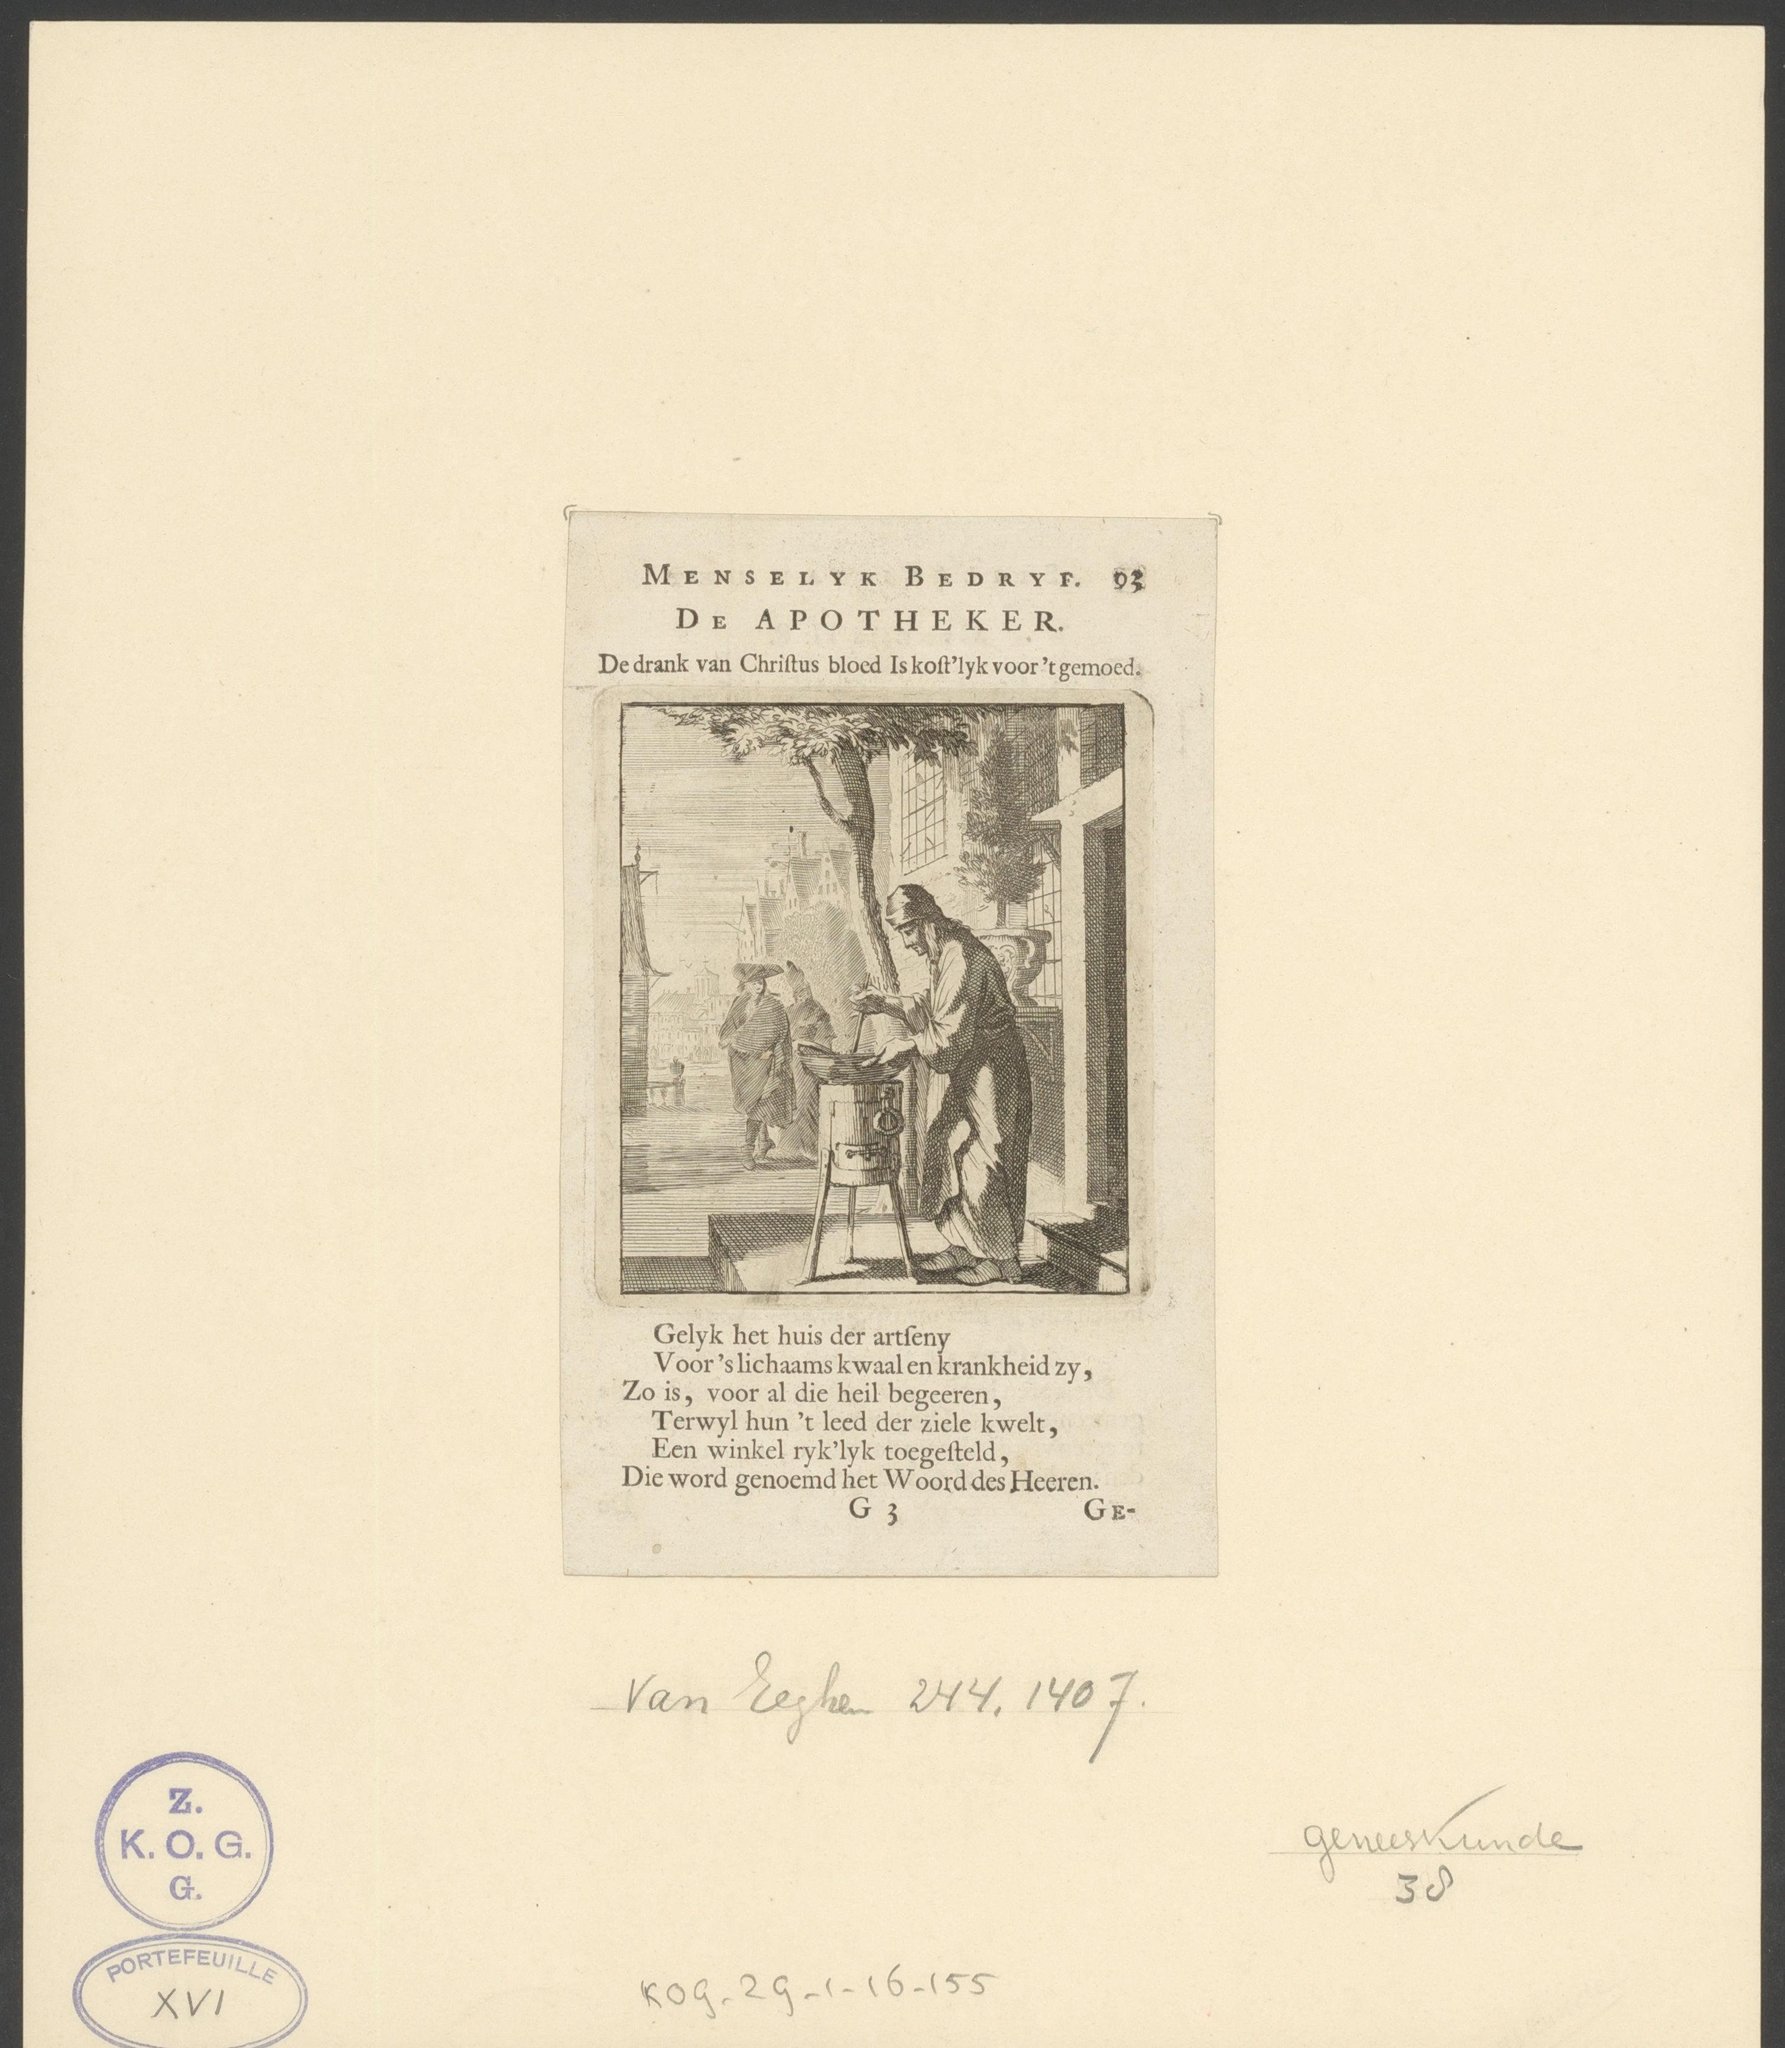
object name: print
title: De Apotheker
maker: jan luyken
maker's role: draughtsman, print maker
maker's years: 1649-1712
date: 1694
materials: paper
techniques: etching, letterpress printing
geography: amsterdam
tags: handicrafts, craftsman at work, pharmacist, druggist, apothecary; pharmacy, drugstore, dispensing chemist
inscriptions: collector's mark, collector's mark: Lugt 1641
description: Een apotheker bereidt op straat een geneesmiddel. Met zesregelig vers onder de plaat. Genummerd rechtsboven: 93. Bedrukt met tekst op achterzijde. Onderwerpsrubrieken binnen de Atlas Zeden en Gewoonten: Onderwijs en Wetenschappen: Geneeskunde.